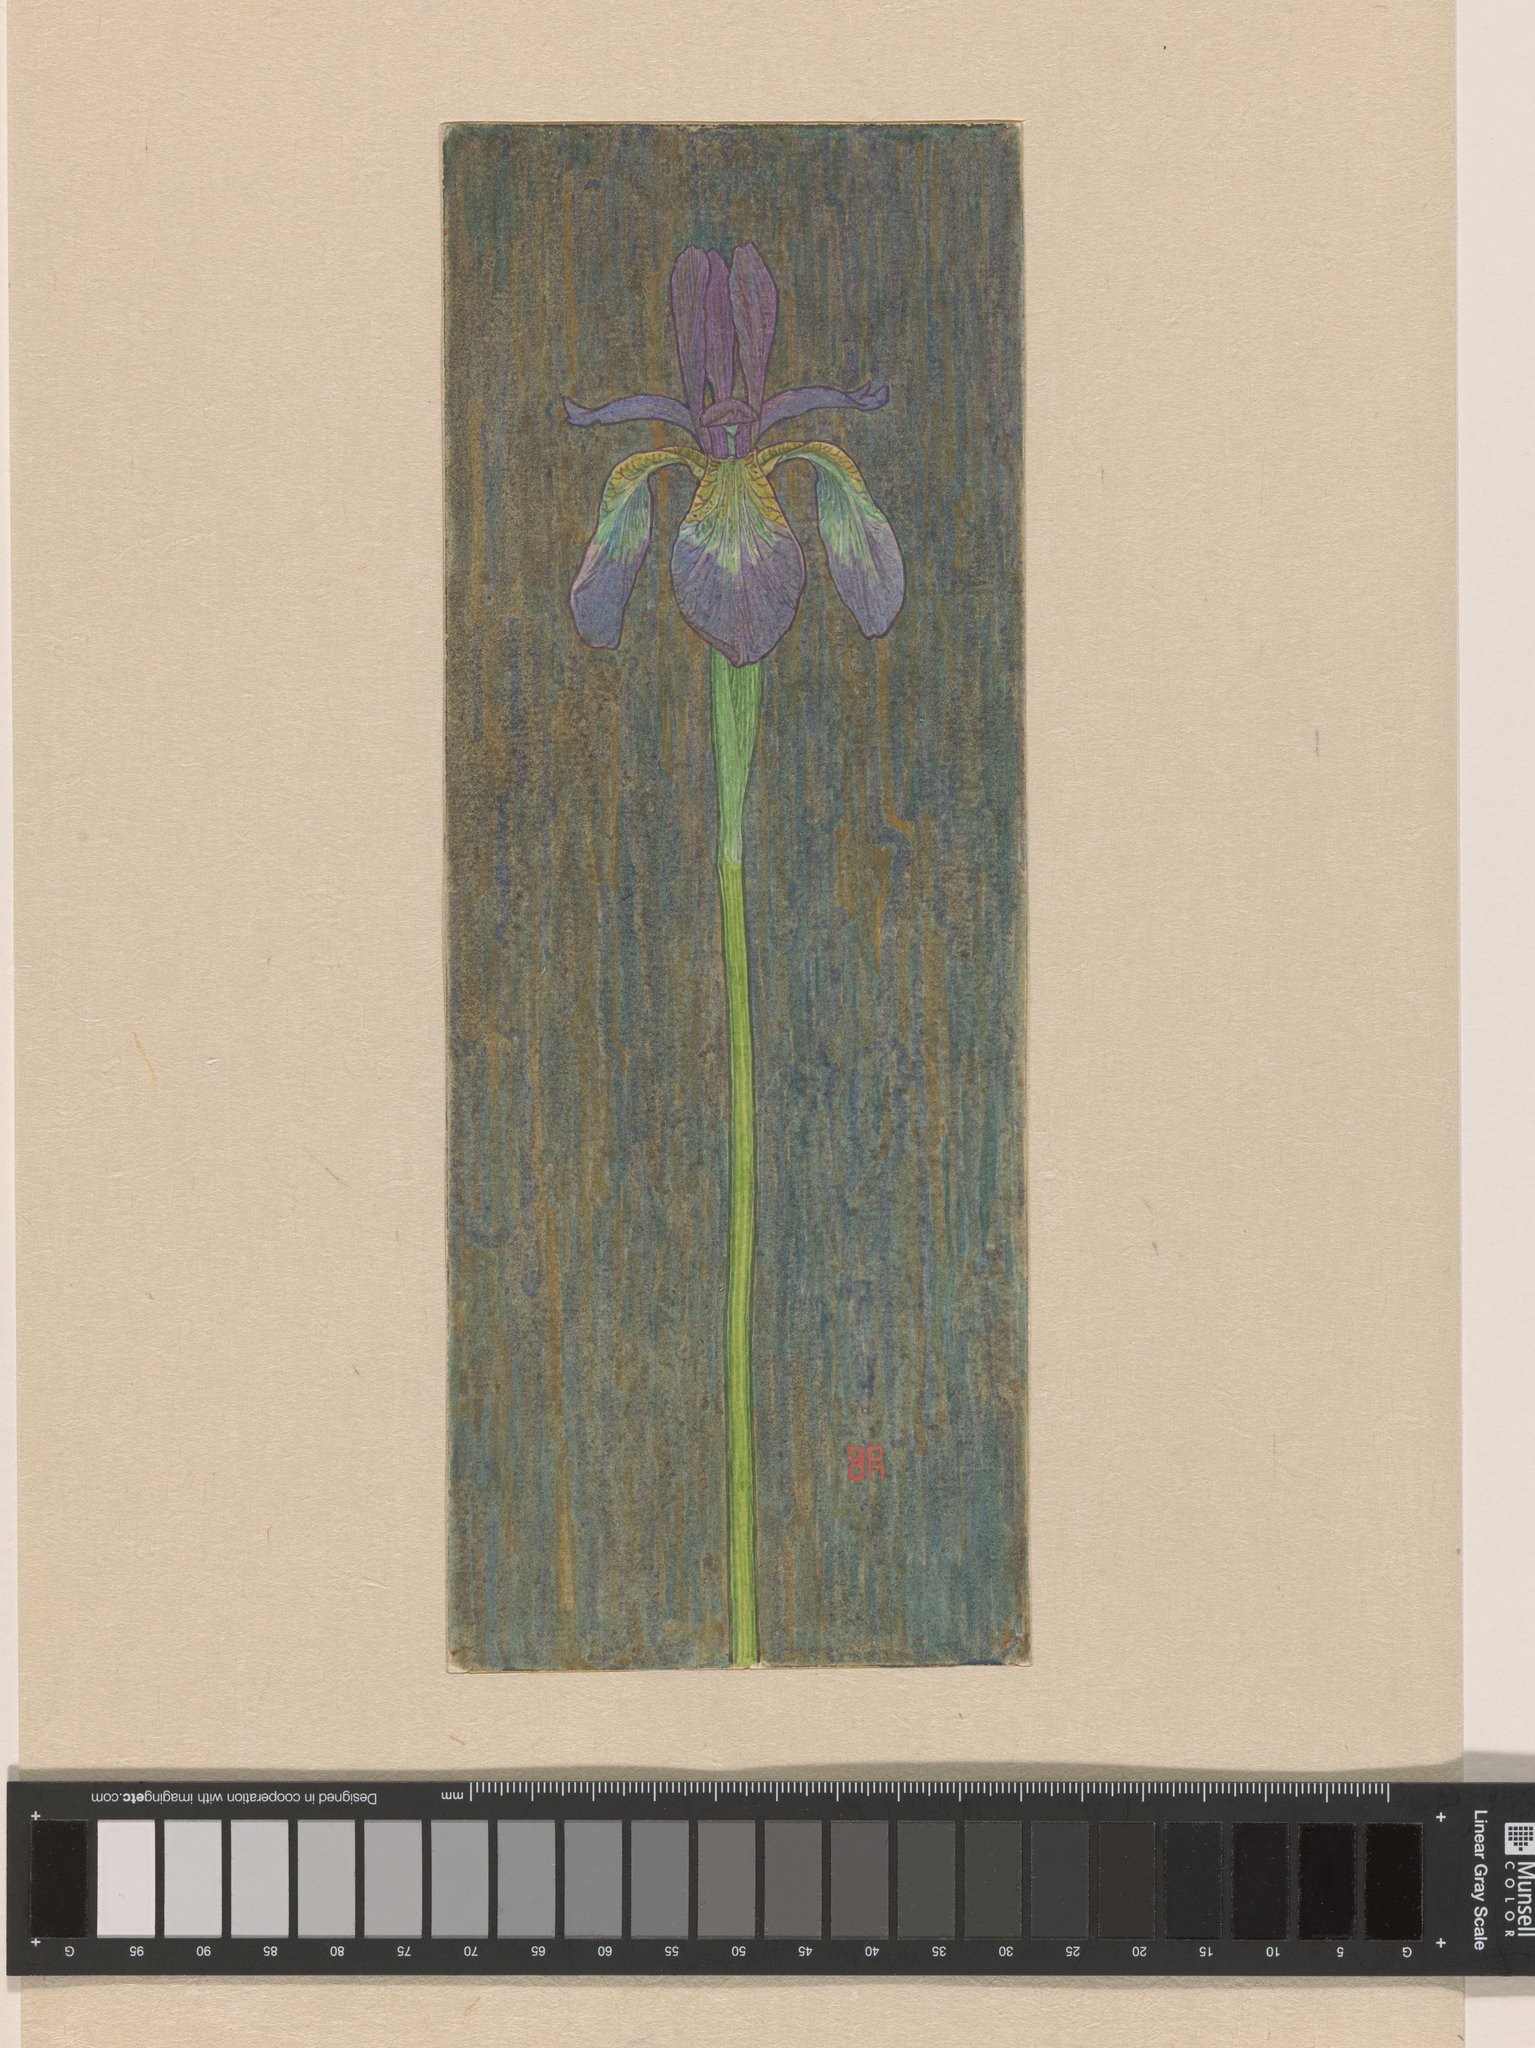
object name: drawing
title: Iris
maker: gijs bosch reitz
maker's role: painter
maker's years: 1860-1938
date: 1900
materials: chalk, ink, paper, pencil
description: Een bloeiende iris op een lange stengel is in het midden tegen een donker gestreept fond geplaatst. Rechtsonder is een rood monogram met de letters BR getekend waarbij de letter B gespiegeld weergegeven is.